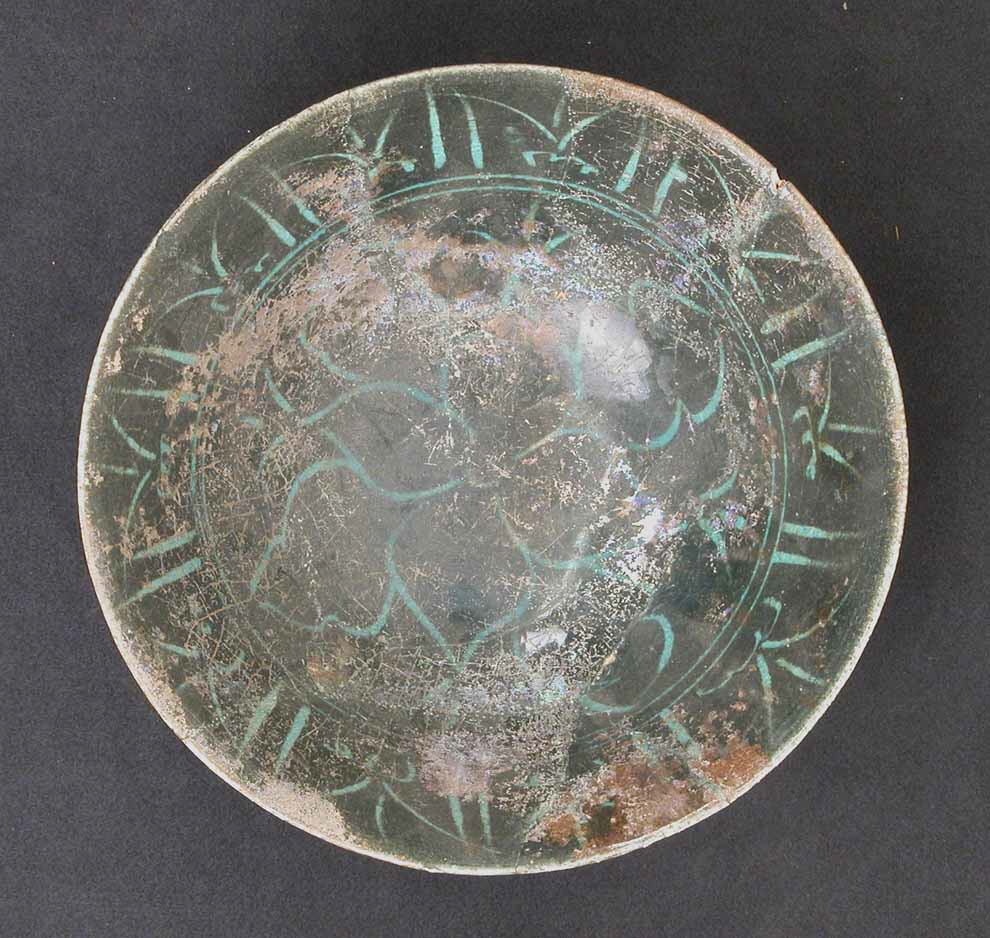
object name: bowl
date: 1201-1300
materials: glaze, stonepaste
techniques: incising, painting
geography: iran